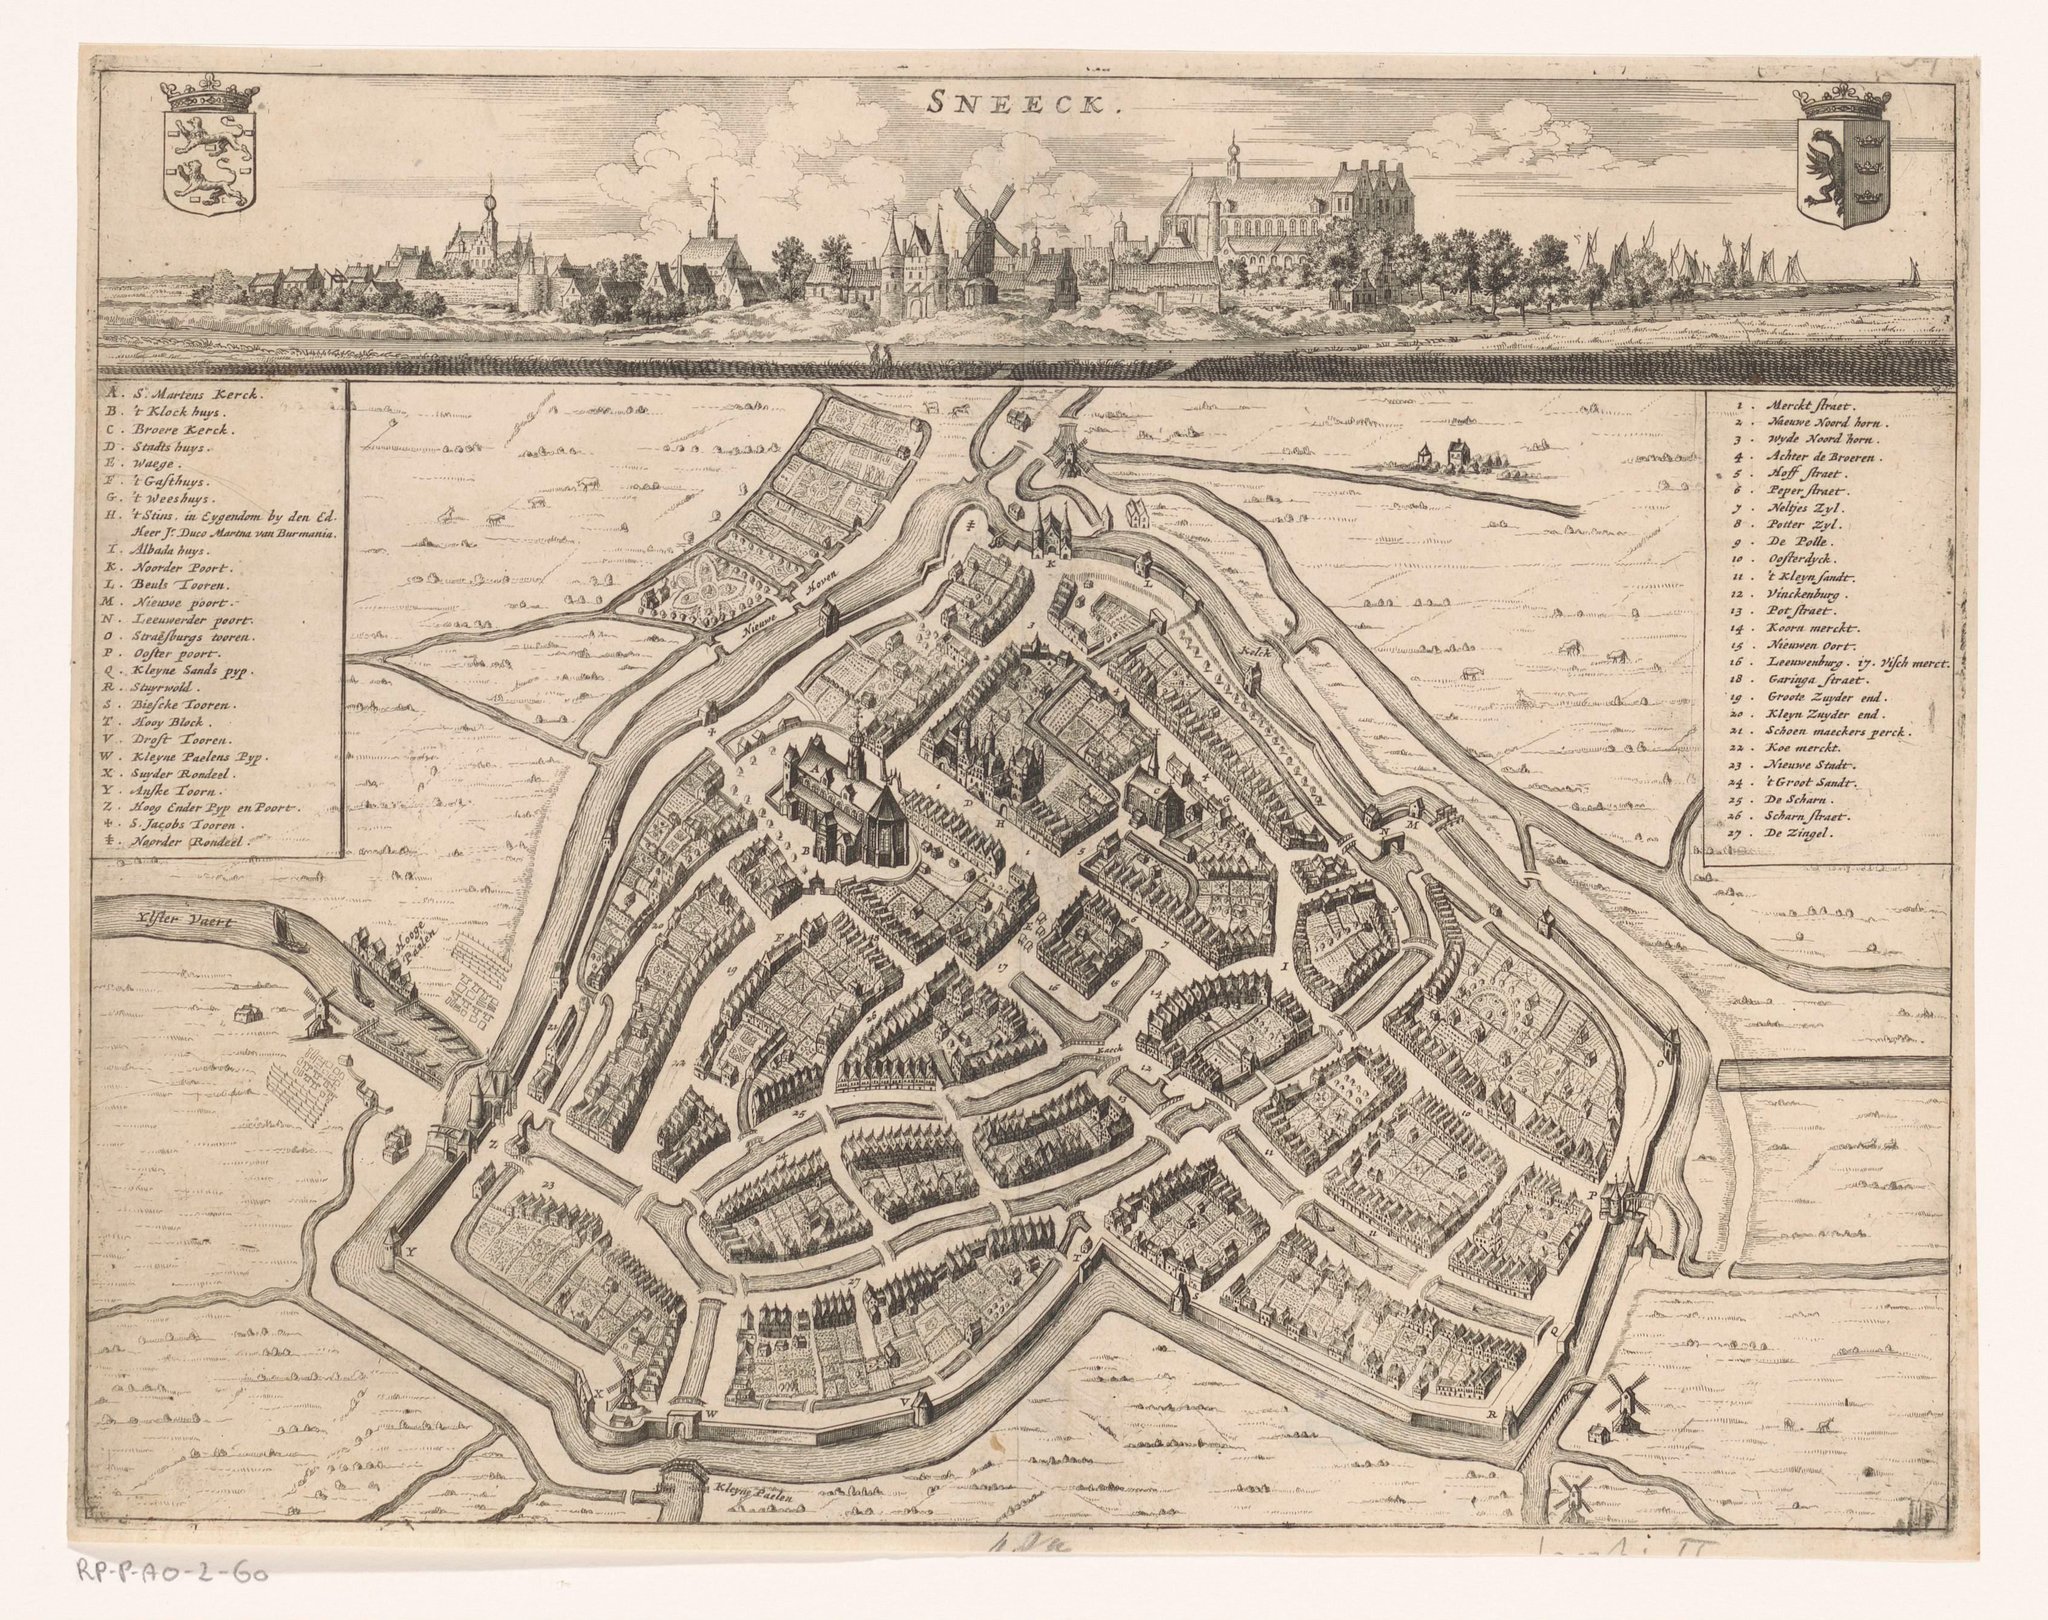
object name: area plan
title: Plattegrond van Sneek met stadsgezicht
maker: jacob van meurs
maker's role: draughtsman, print maker, publisher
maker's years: 1619-1680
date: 1664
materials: paper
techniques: engraving, etching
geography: amsterdam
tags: coat of arms (as symbol of the state, etc.), city-view, and landscape with man-made constructions, maps of cities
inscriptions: collector's mark: Lugt 2228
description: Bovenaan een stadsgezicht van Sneek met daarop links het wapen van Friesland en rechts dat van Sneek. Daaronder een plattegrond van de stad in vogelvluchtperspectief. Links- en rechts legenda.